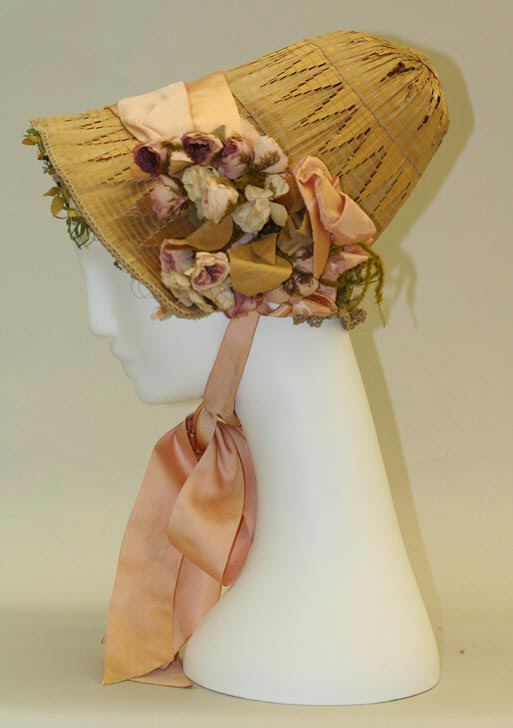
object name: bonnet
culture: american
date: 1850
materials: silk, fiber